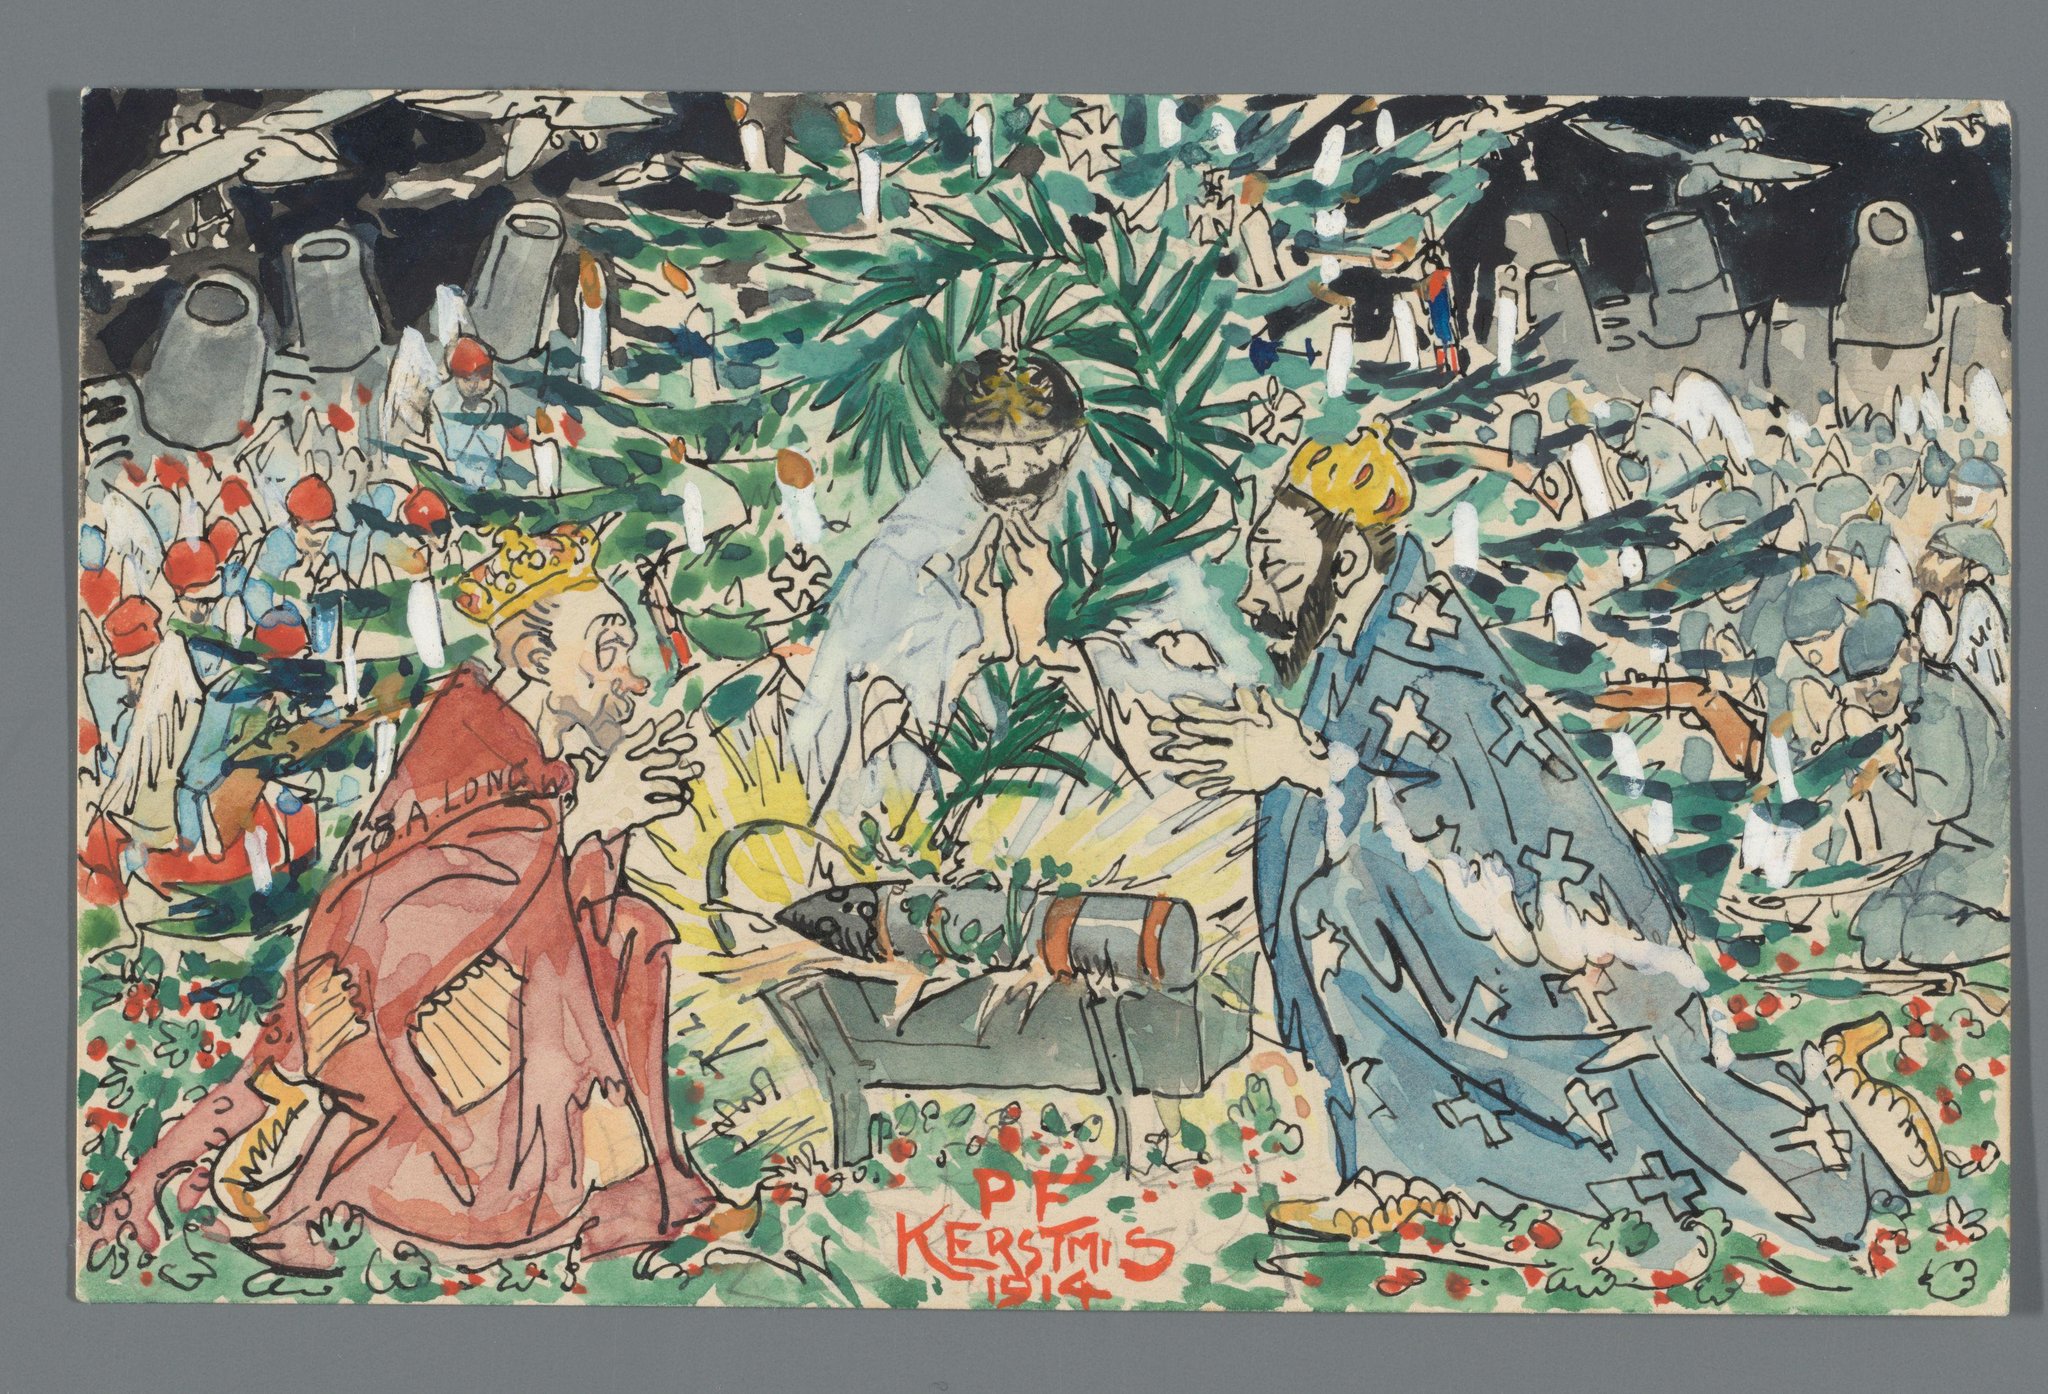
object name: drawing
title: Briefkaart aan Jan Ponstijn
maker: leo gestel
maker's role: draughtsman, print maker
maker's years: 1881-1941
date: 1912-1914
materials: cardboard, paint, ink, pencil, watercolor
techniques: brush, pen, writing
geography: woerden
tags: amsterdam, draughtsman, jan petrus ponstijn, christmas tree, adoration of the christ-child ~ christ's birth, war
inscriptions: date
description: Briefkaart met karikatuur van George V, Wilhelm II en Nicolaas II als de Drie Koningen die een bom in een kribbe aanbidden. Op de achtergrond een kerstboom, wapentuig en soldaten. De briefkaart is ongelopen en maakt deel uit van een album.